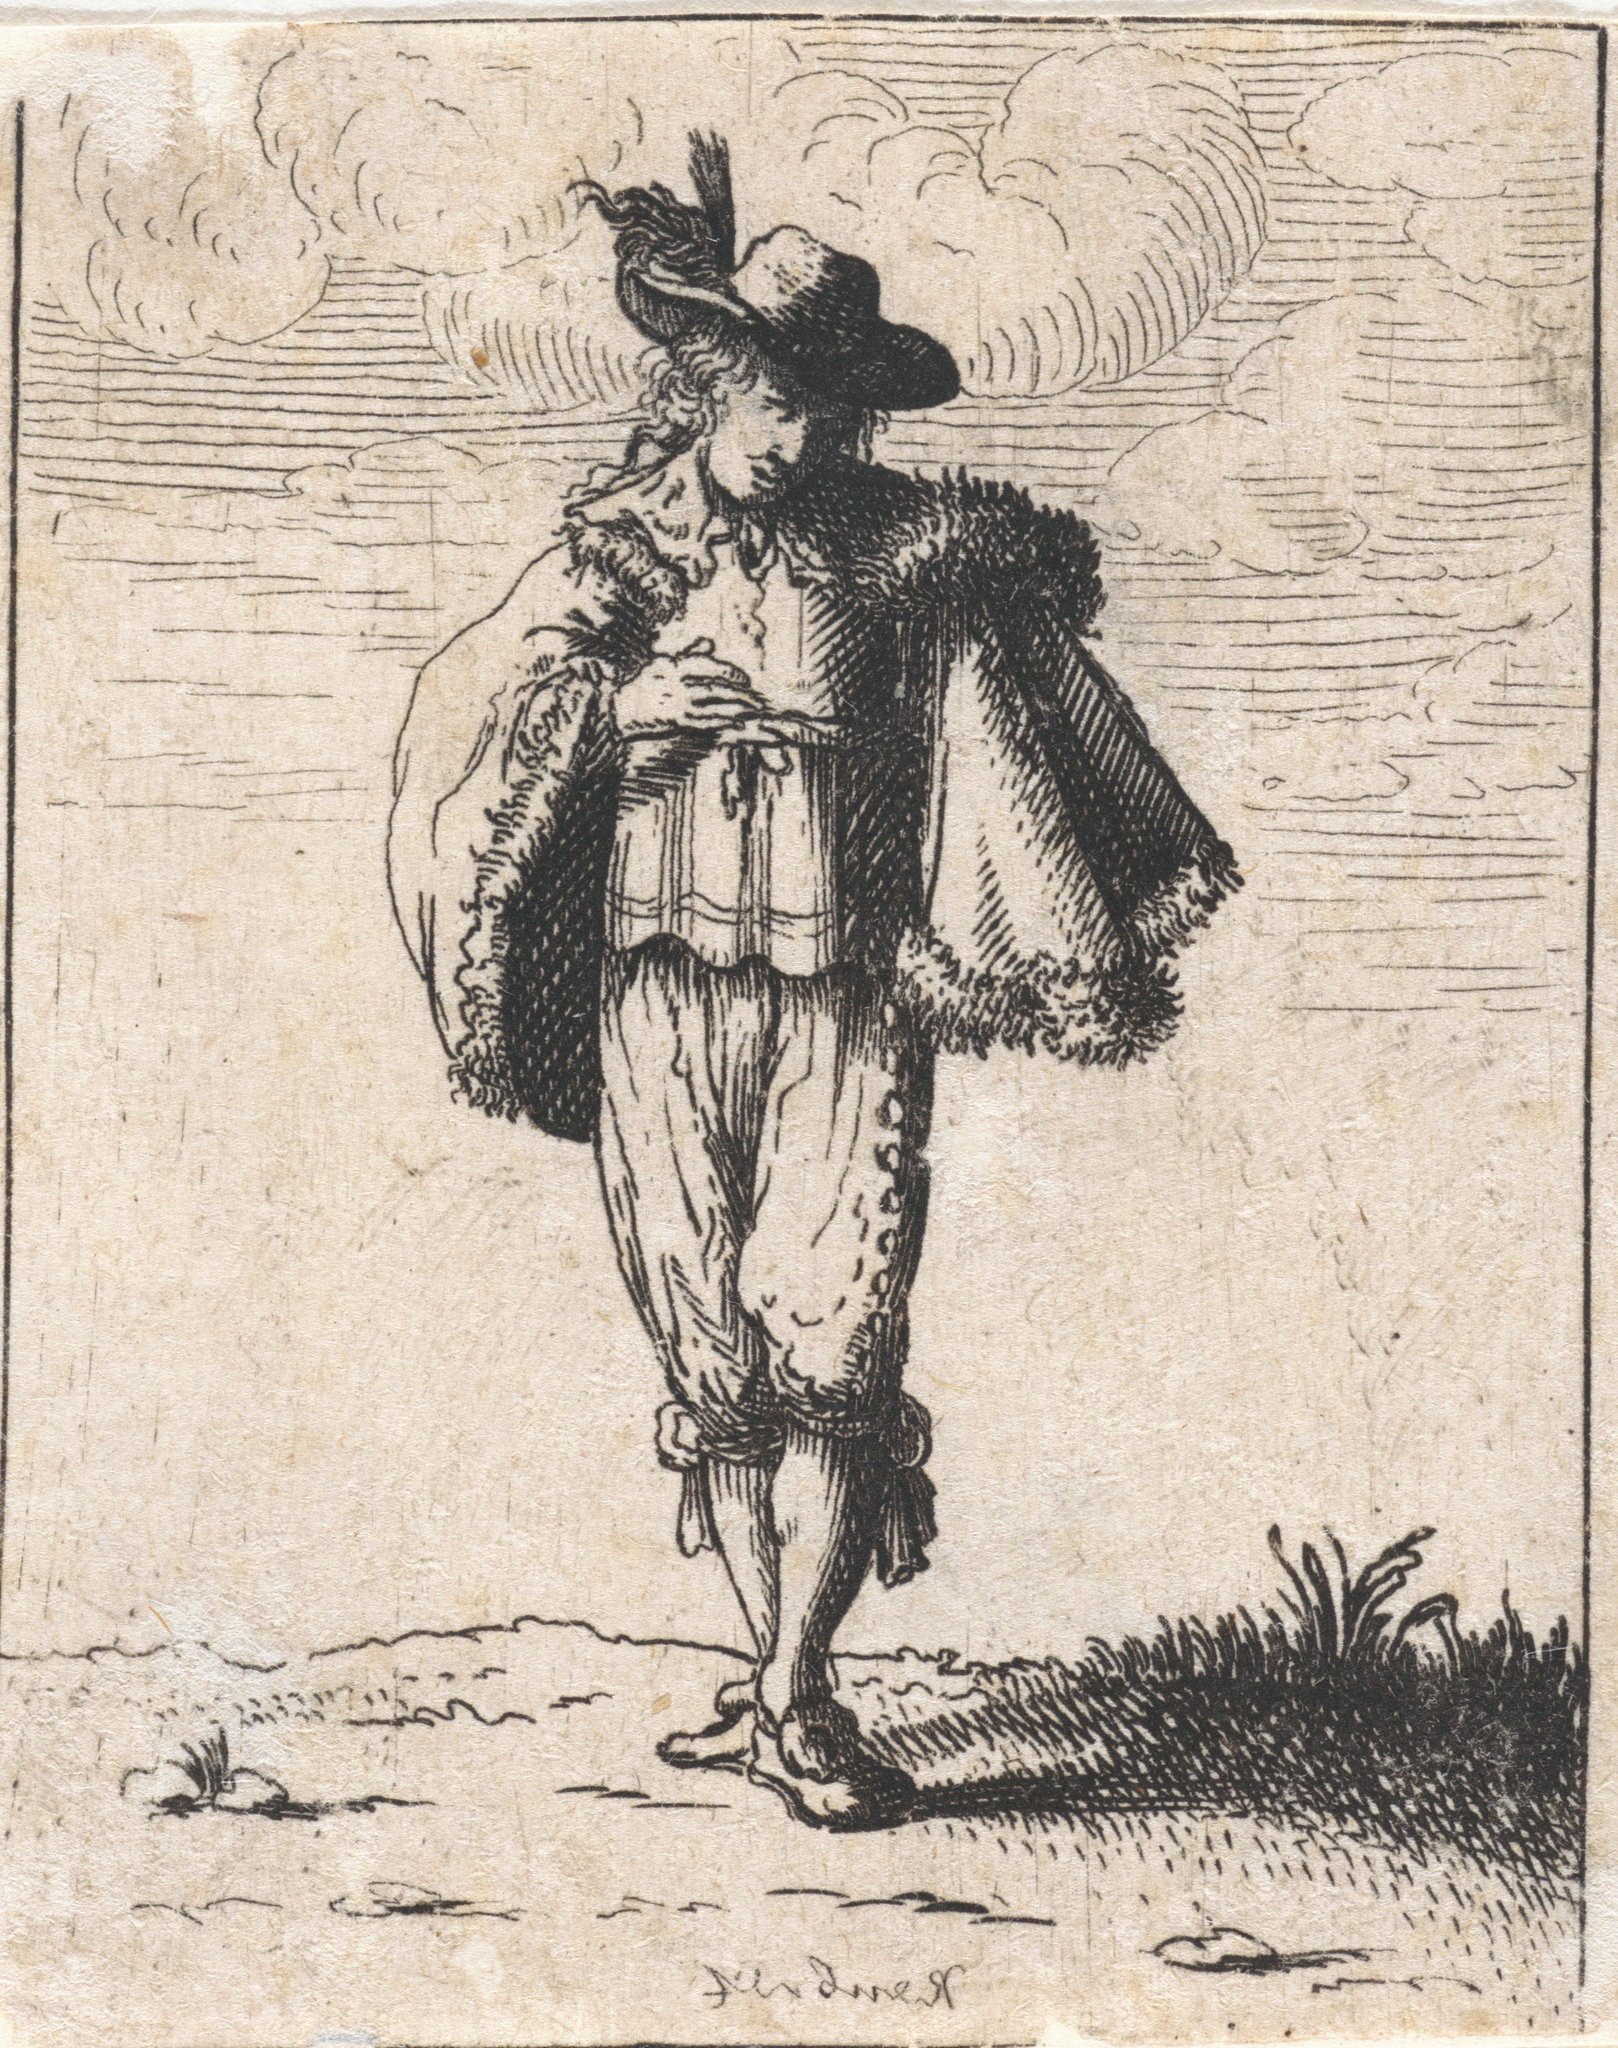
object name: print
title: Man met cape en hoed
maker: Anonymous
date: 1632-1682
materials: paper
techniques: etching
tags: cape (+ men's clothes), cape (+ fur used for clothes), head-gear: hat (+ men's clothes)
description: Een elegant geklede man draagt een met bont gevoerde korte mantel en op zijn hoofd een hoed met een rand.